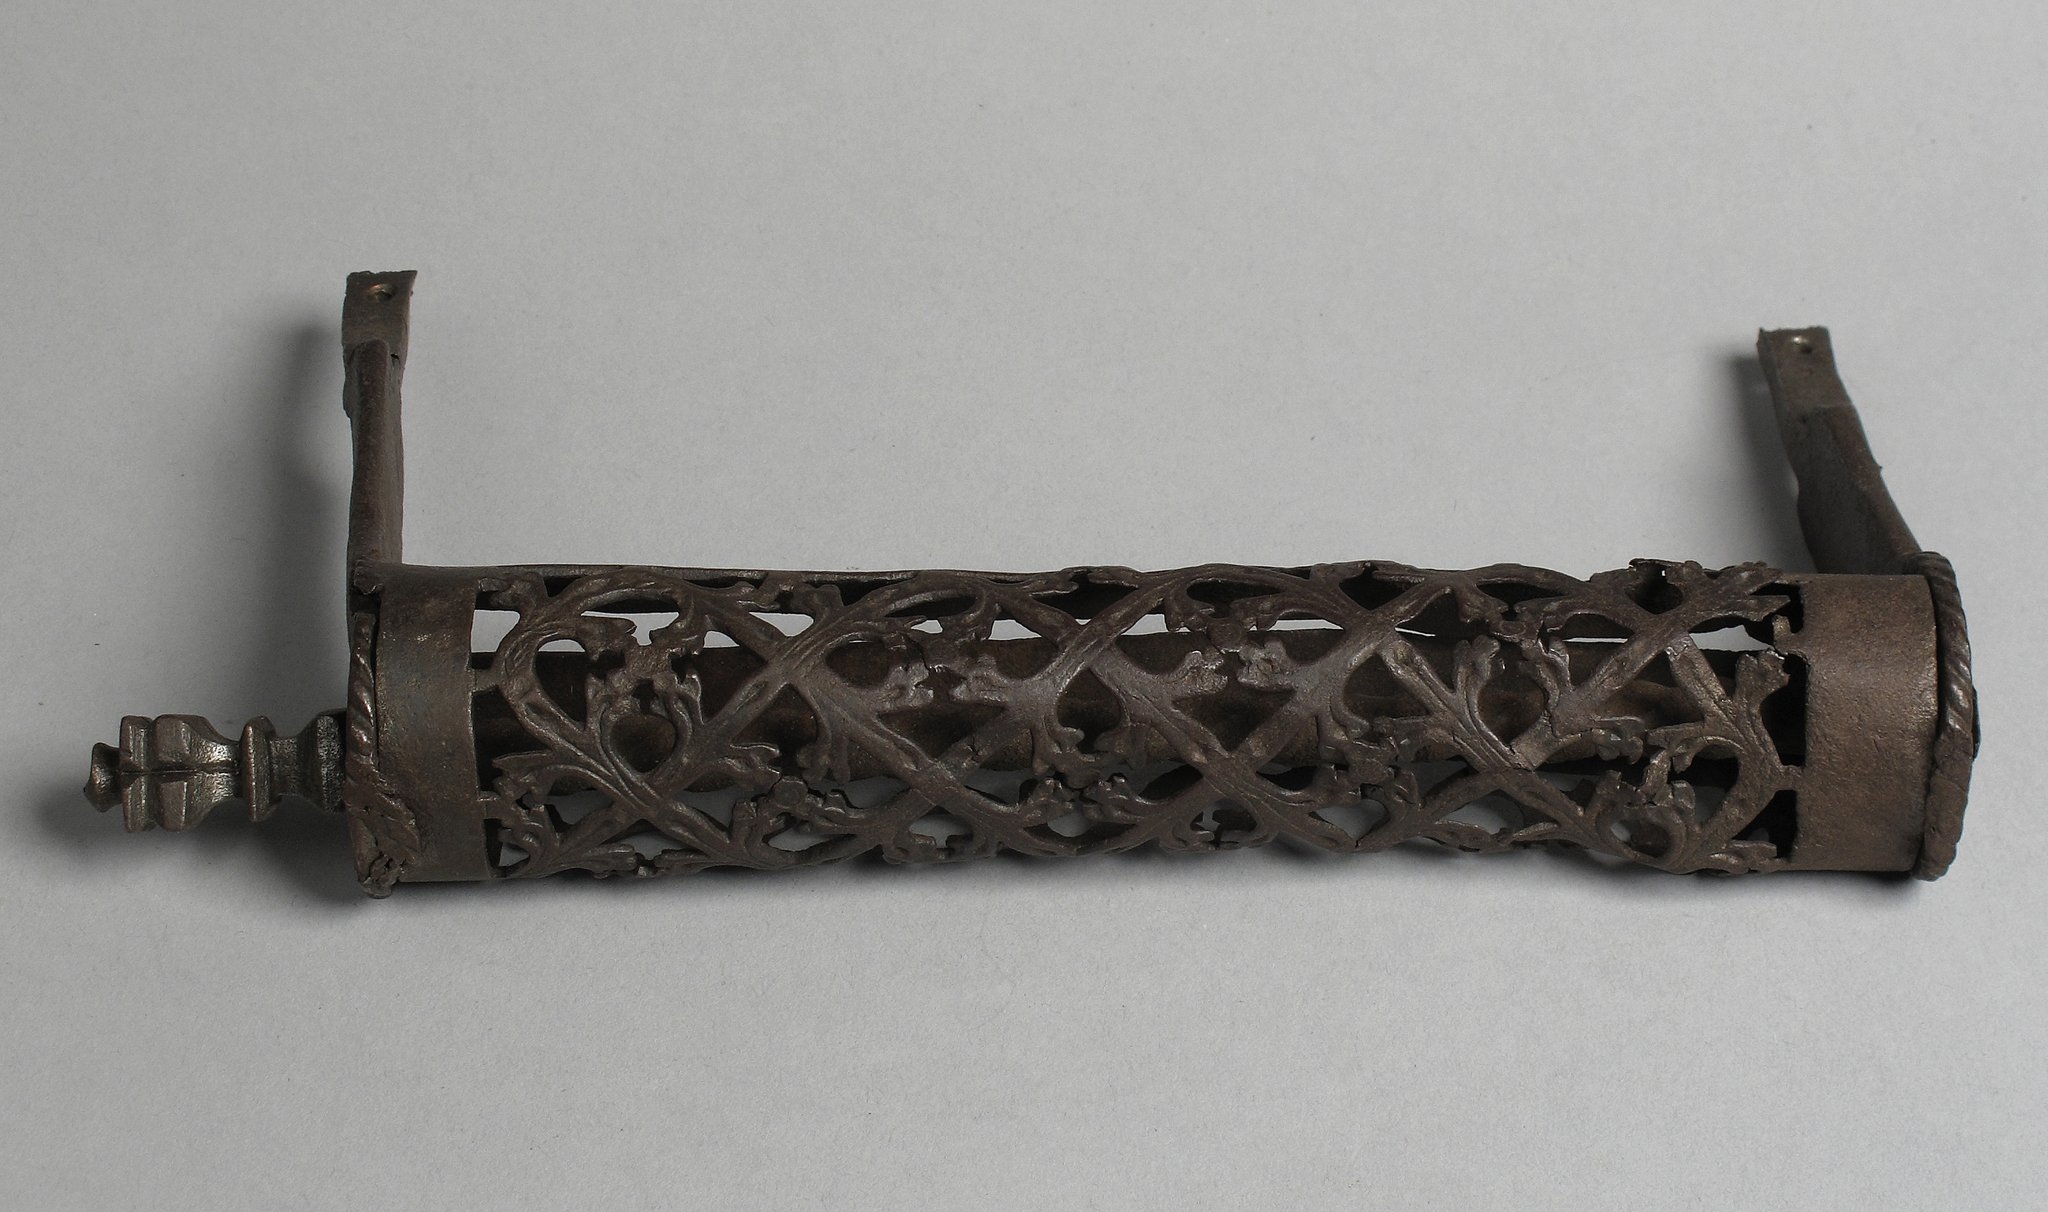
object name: door pull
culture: european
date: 1401-1600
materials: iron